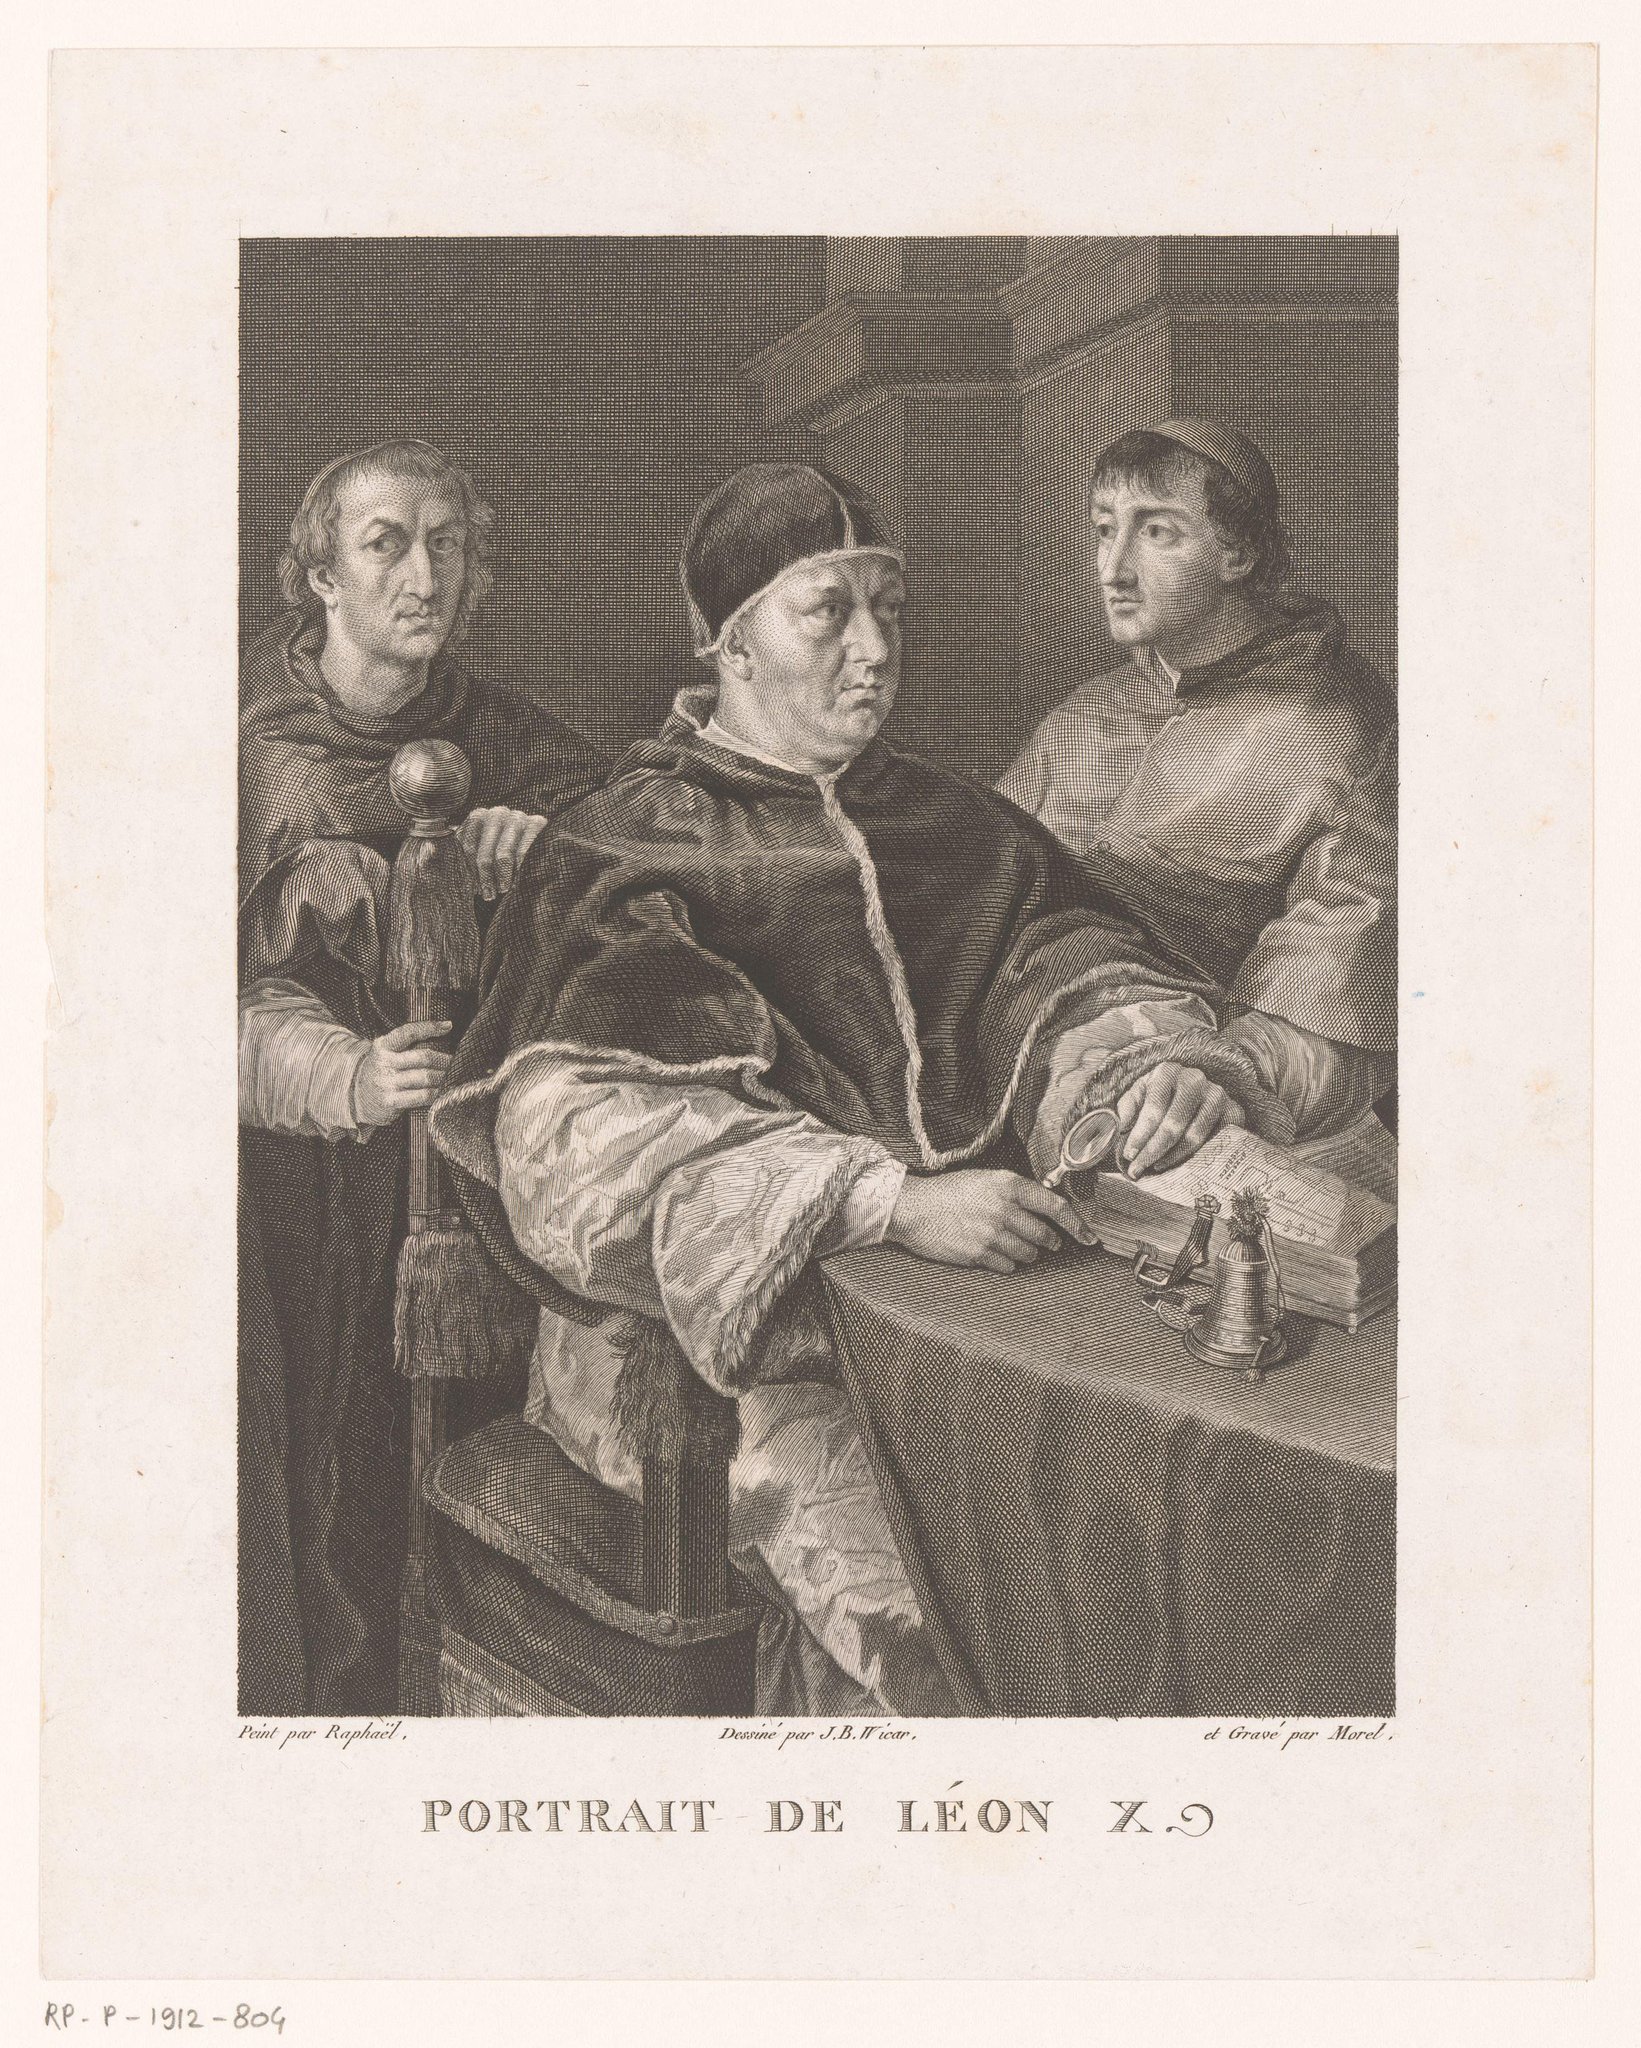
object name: print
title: Portrait de Léon X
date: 1775-1829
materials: paper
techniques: engraving, etching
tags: leo x, historical persons, pope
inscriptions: collector's mark: Lugt 2228